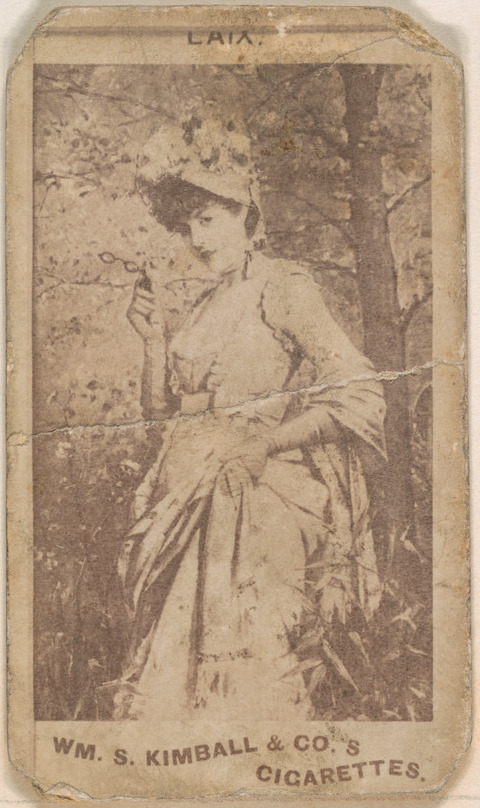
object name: photograph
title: Miss Laix, from the Actresses series (N203) issued by Wm. S. Kimball & Co.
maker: william s. kimball & company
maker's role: publisher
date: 1889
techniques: color lithograph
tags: portraits,women,actresses